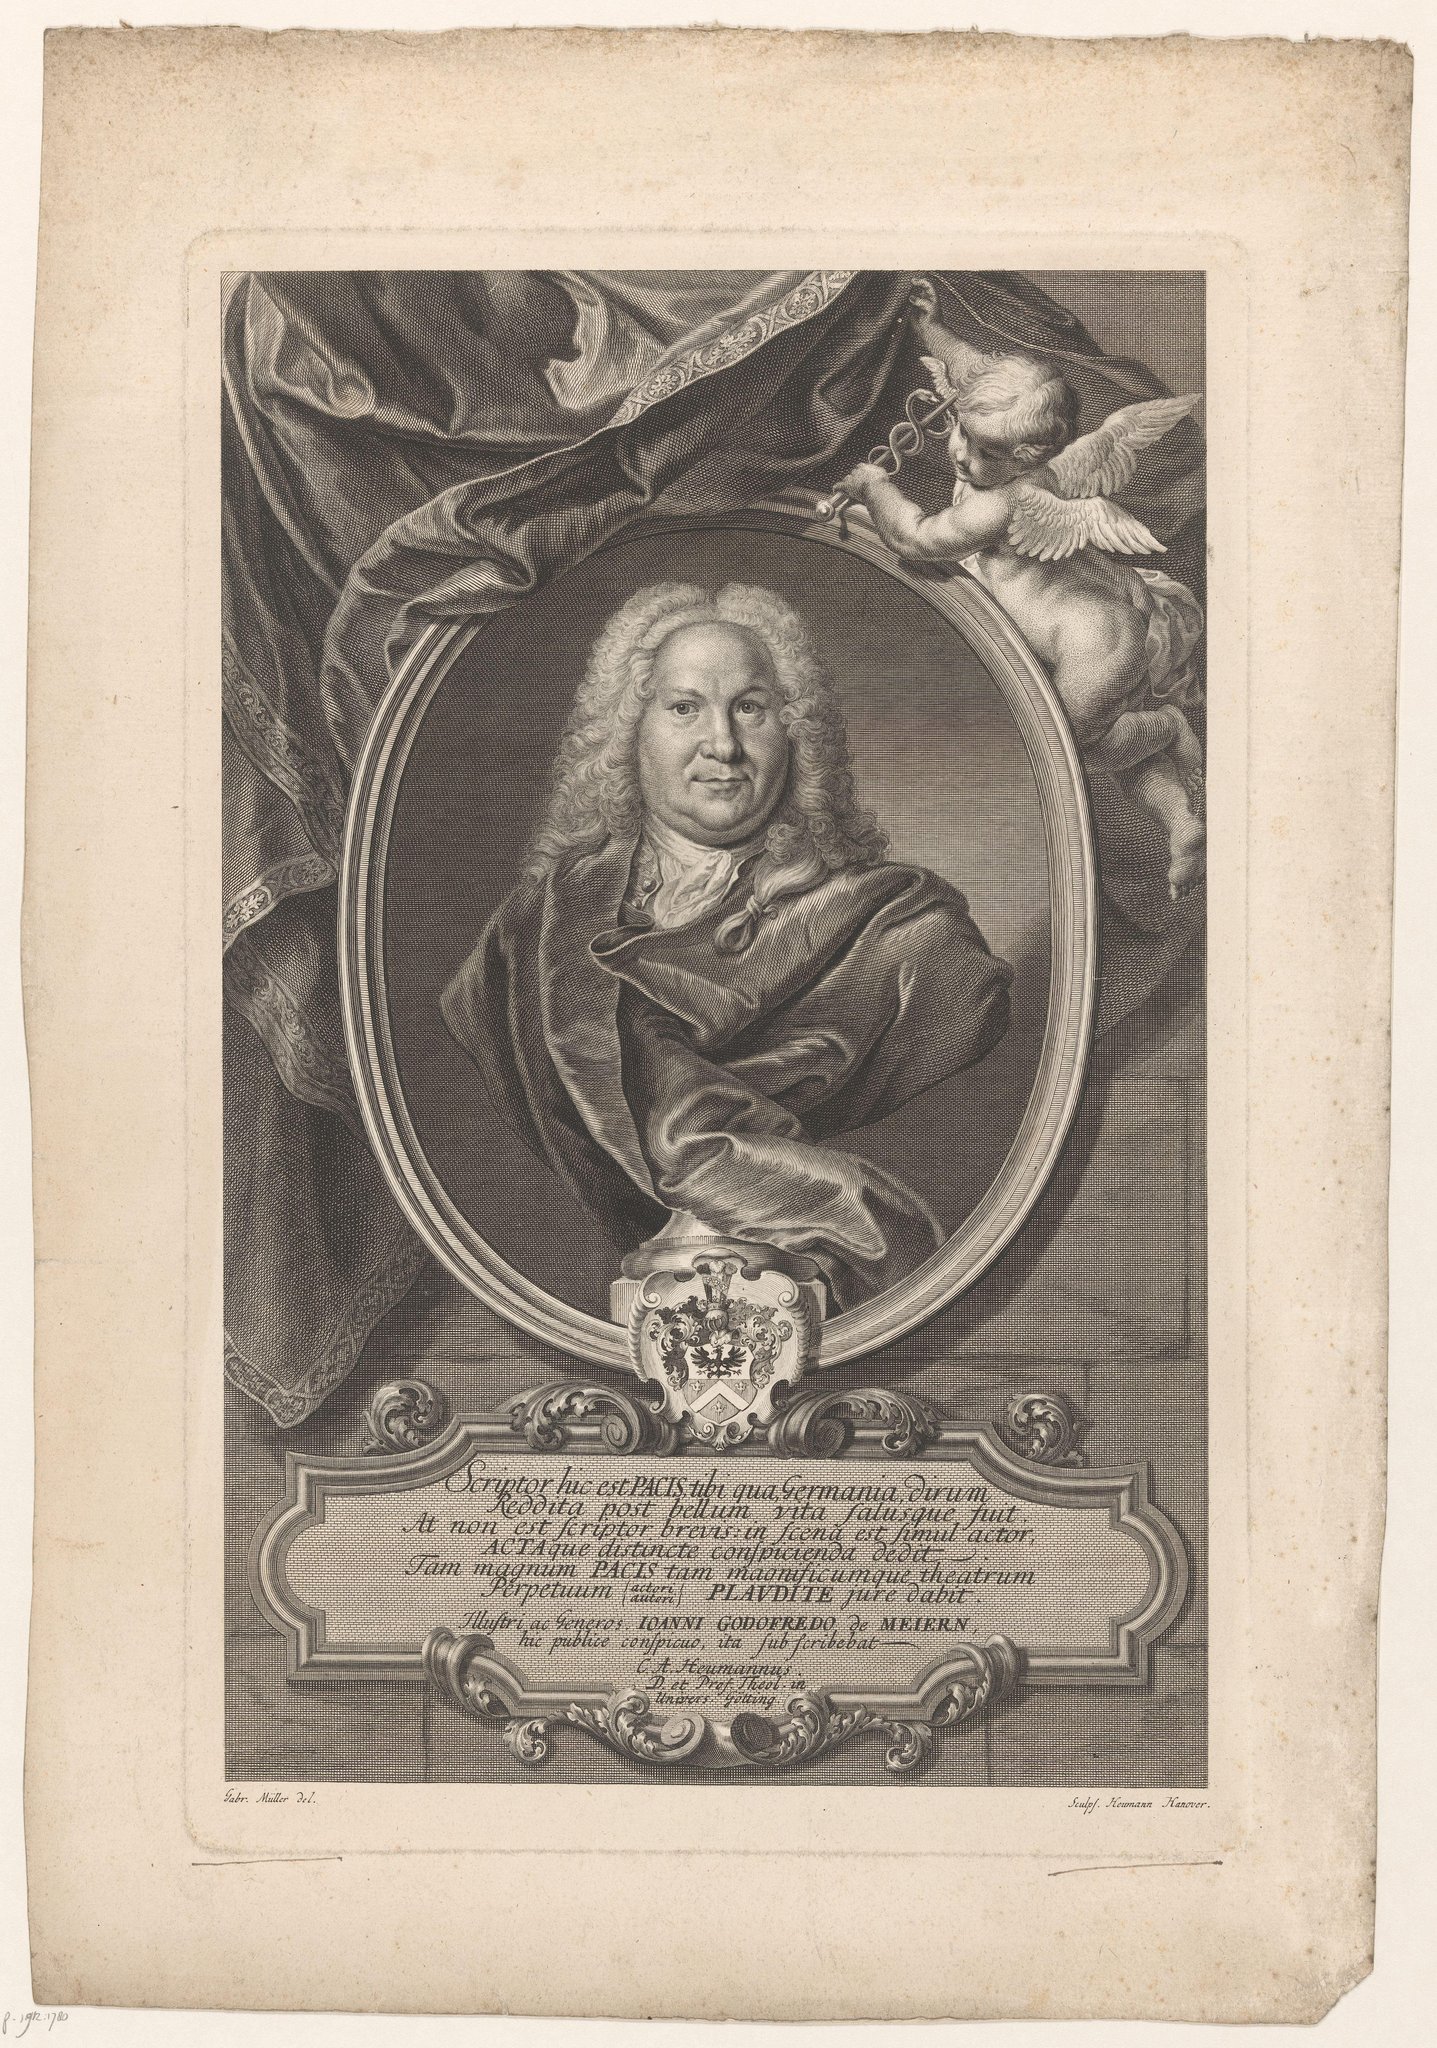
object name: print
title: Portret van Johann Godfried von Meiern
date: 1701-1759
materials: paper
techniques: engraving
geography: hannover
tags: johann gottfried von meiern, historical persons, armorial bearing, heraldry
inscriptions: collector's mark: Lugt 2228